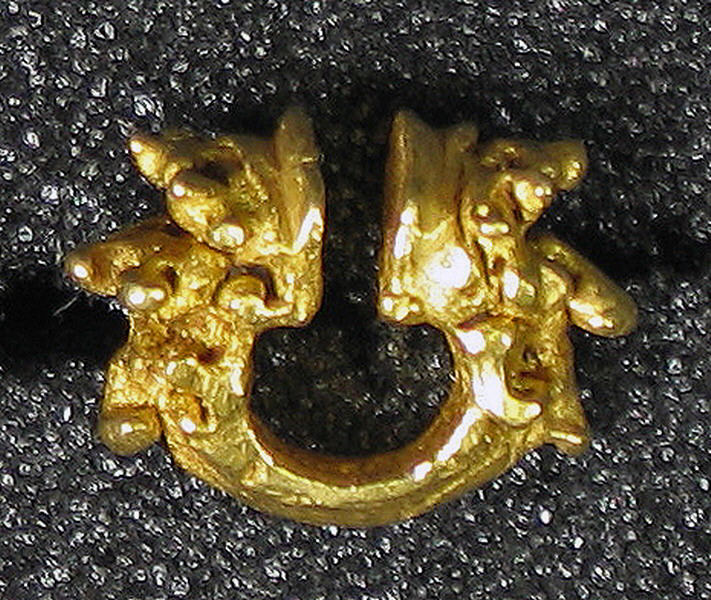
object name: earring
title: Earrings with Foliate Decoration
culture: indonesian, central java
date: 701-1200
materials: gold